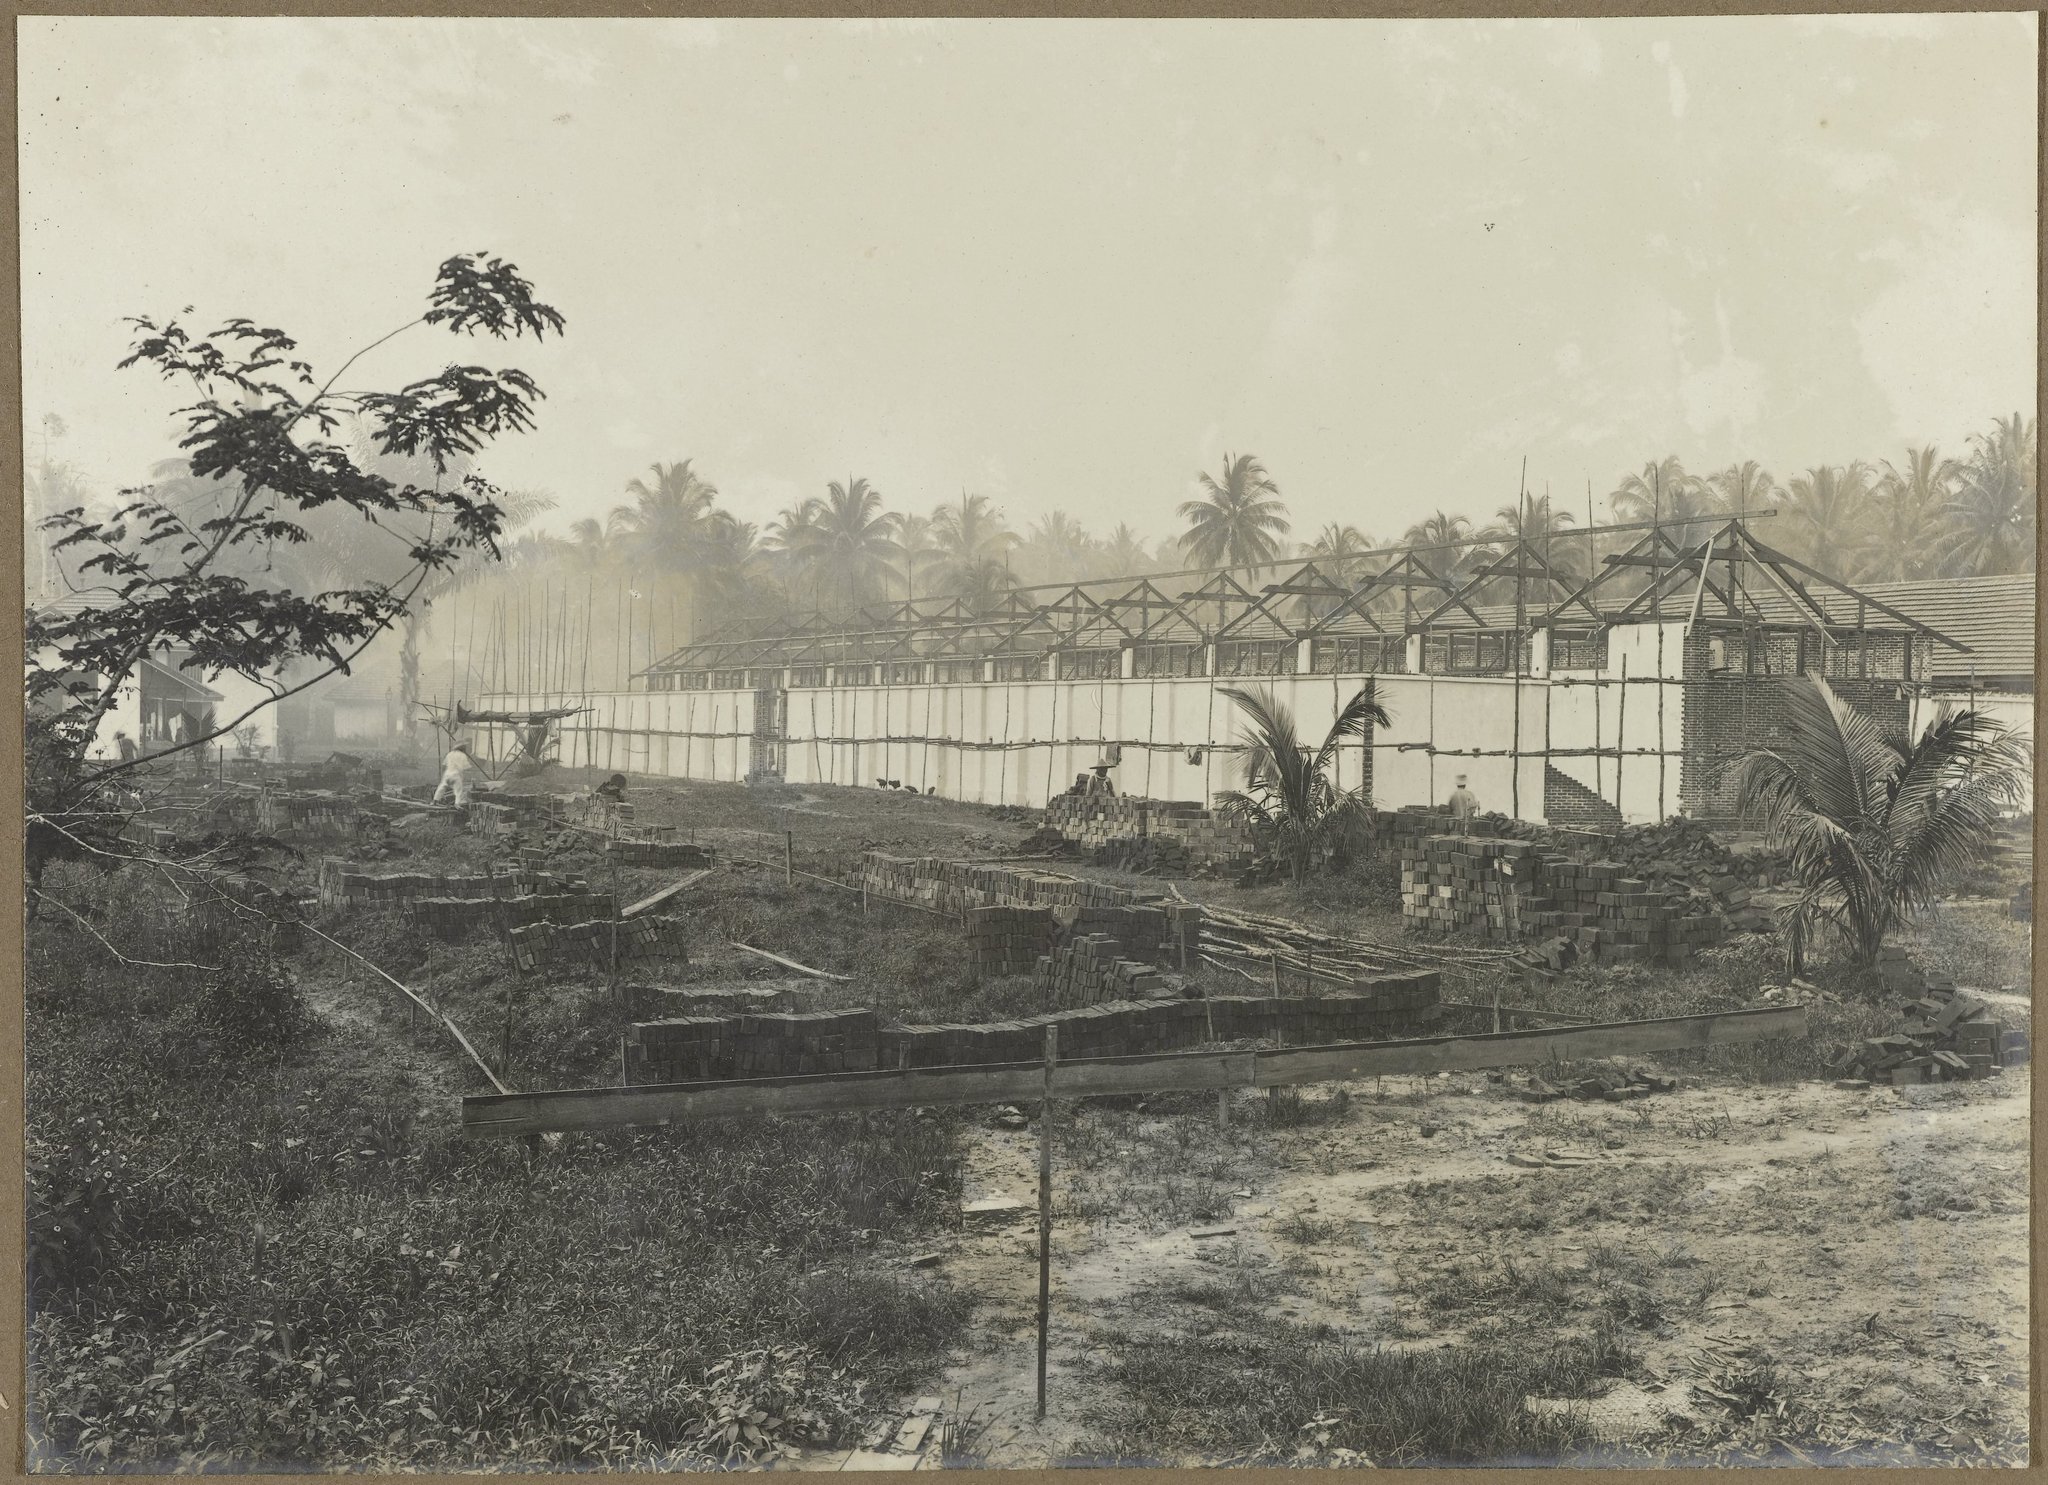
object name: photograph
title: Bouw van een bedrijfspand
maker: Anonymous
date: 1914-1919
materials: photographic support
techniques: gelatin silver print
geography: medan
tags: making the overground structures (~ building activities), representation of real building (either existing or having existed), architecture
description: De bouw van een bedrijfspand, waarschijnlijk te Medan, gezien vanaf de achterzijde. Foto in het fotoalbum van het Nederlandse architectenbureau en aannemersbedrijf Bennink en Riphagen te Medan in de jaren ca. 1914-1919.